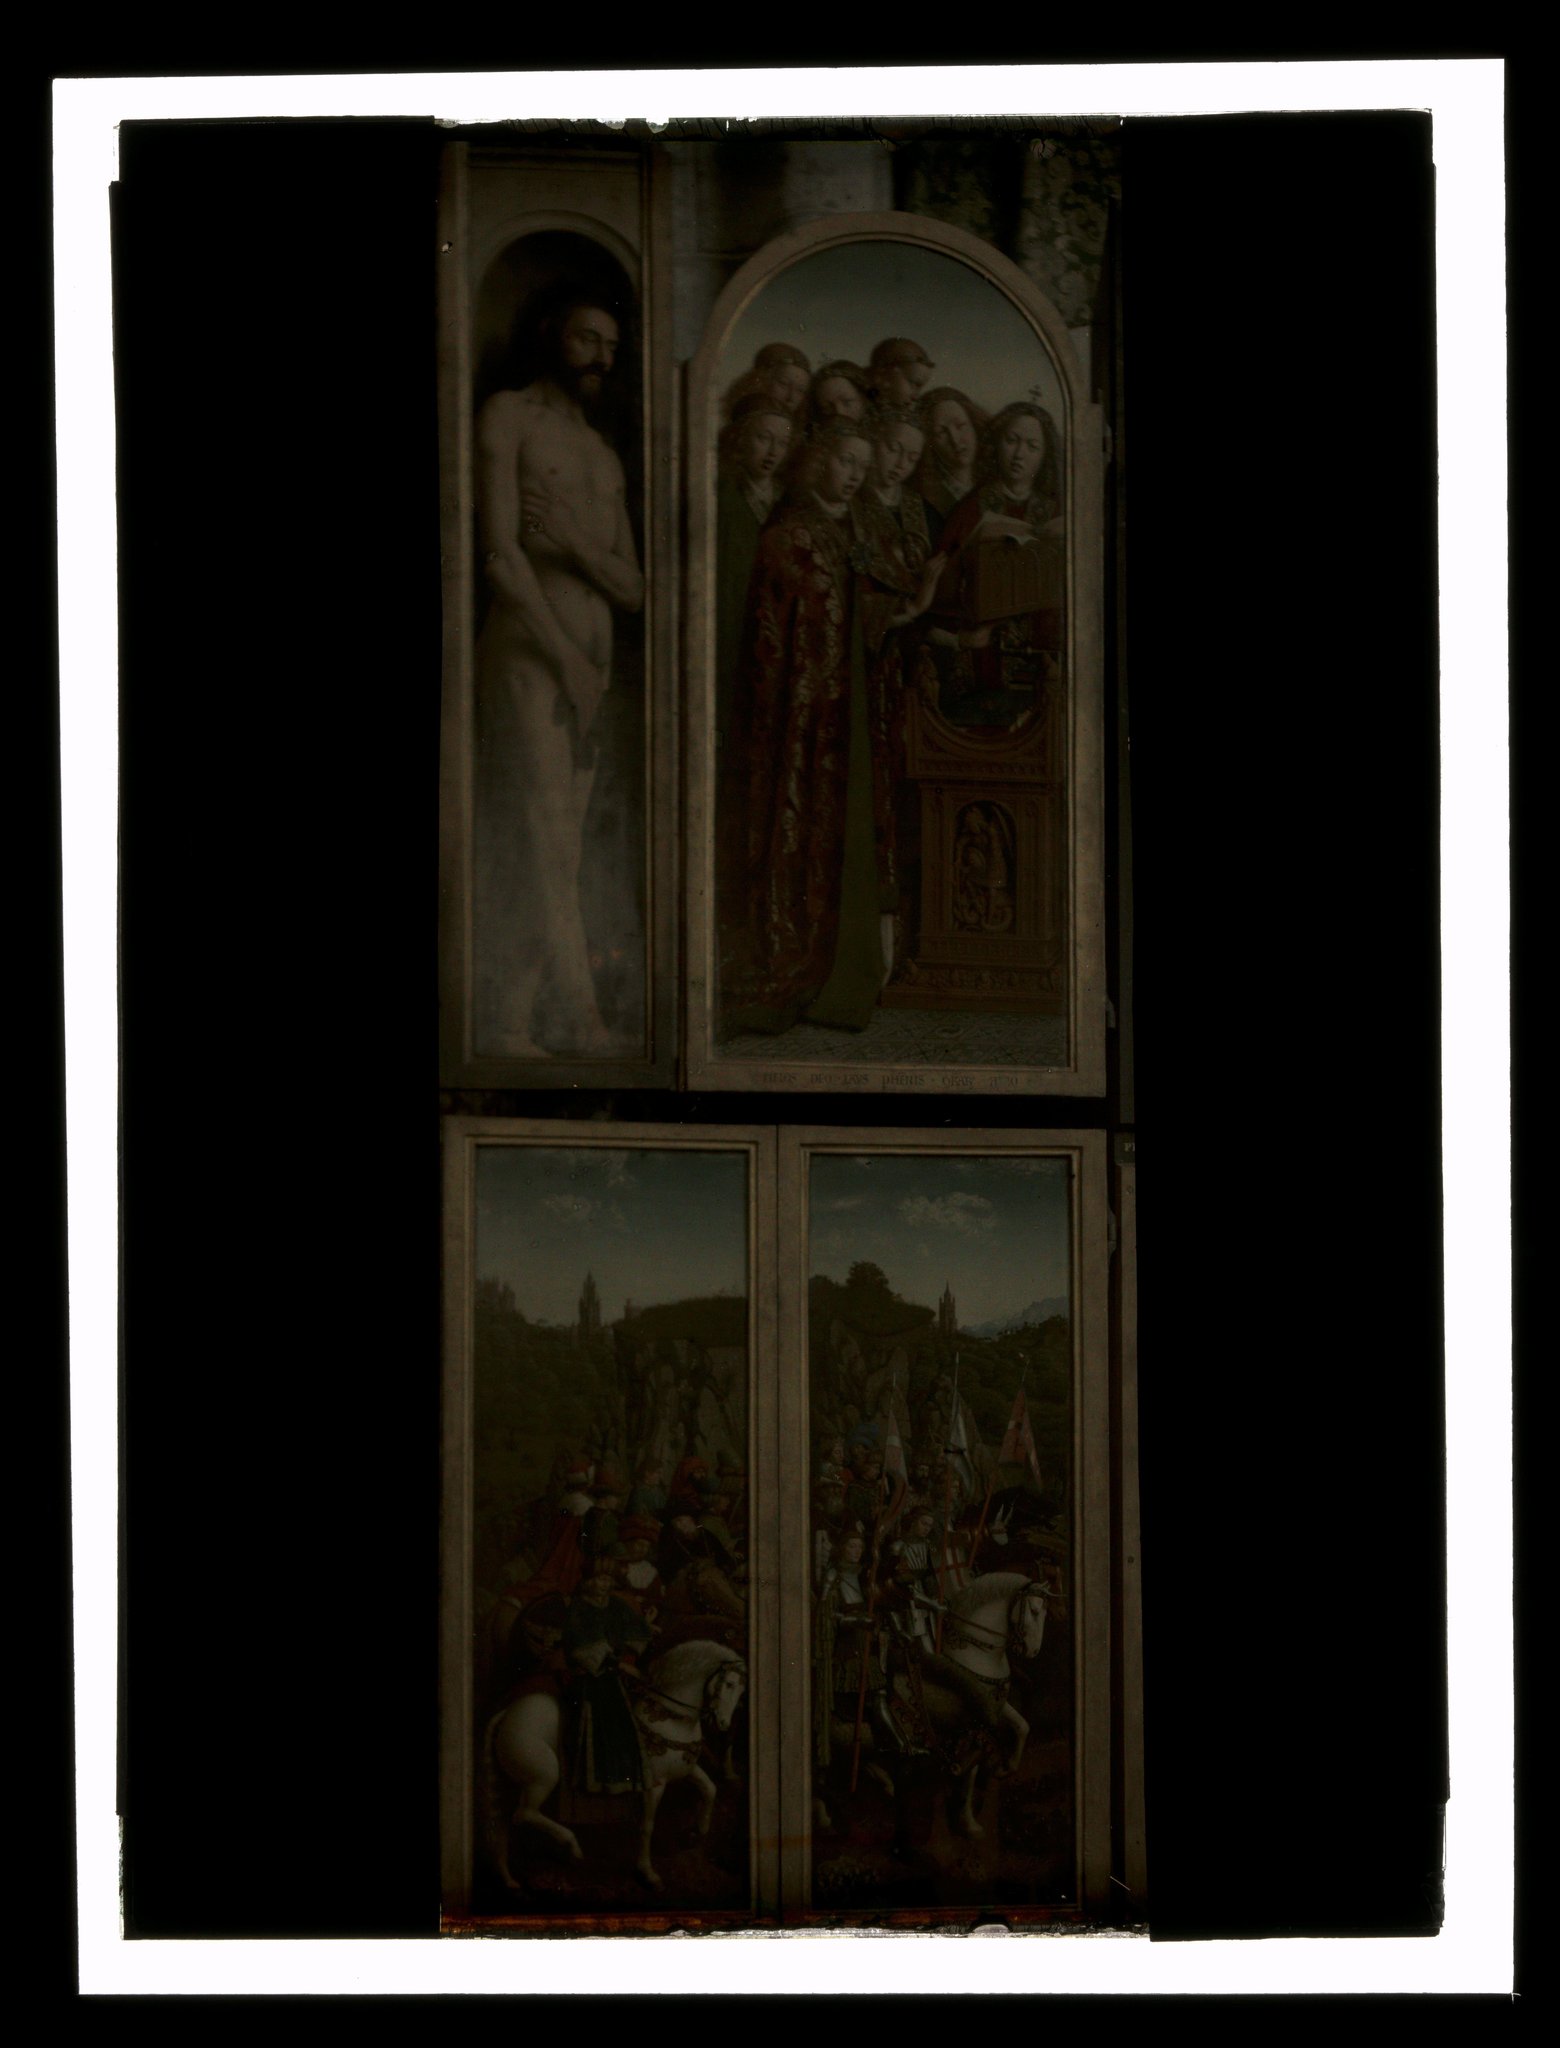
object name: photograph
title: Reproductie (autochroom) van het altaarstuk De aanbidding van het Lam Gods door Hubert en Jan van Eyck, opgesteld in de Sint-Baafskathedraal, Gent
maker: Anonymous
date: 1934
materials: cardboard, glass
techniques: autochrome process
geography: ghent